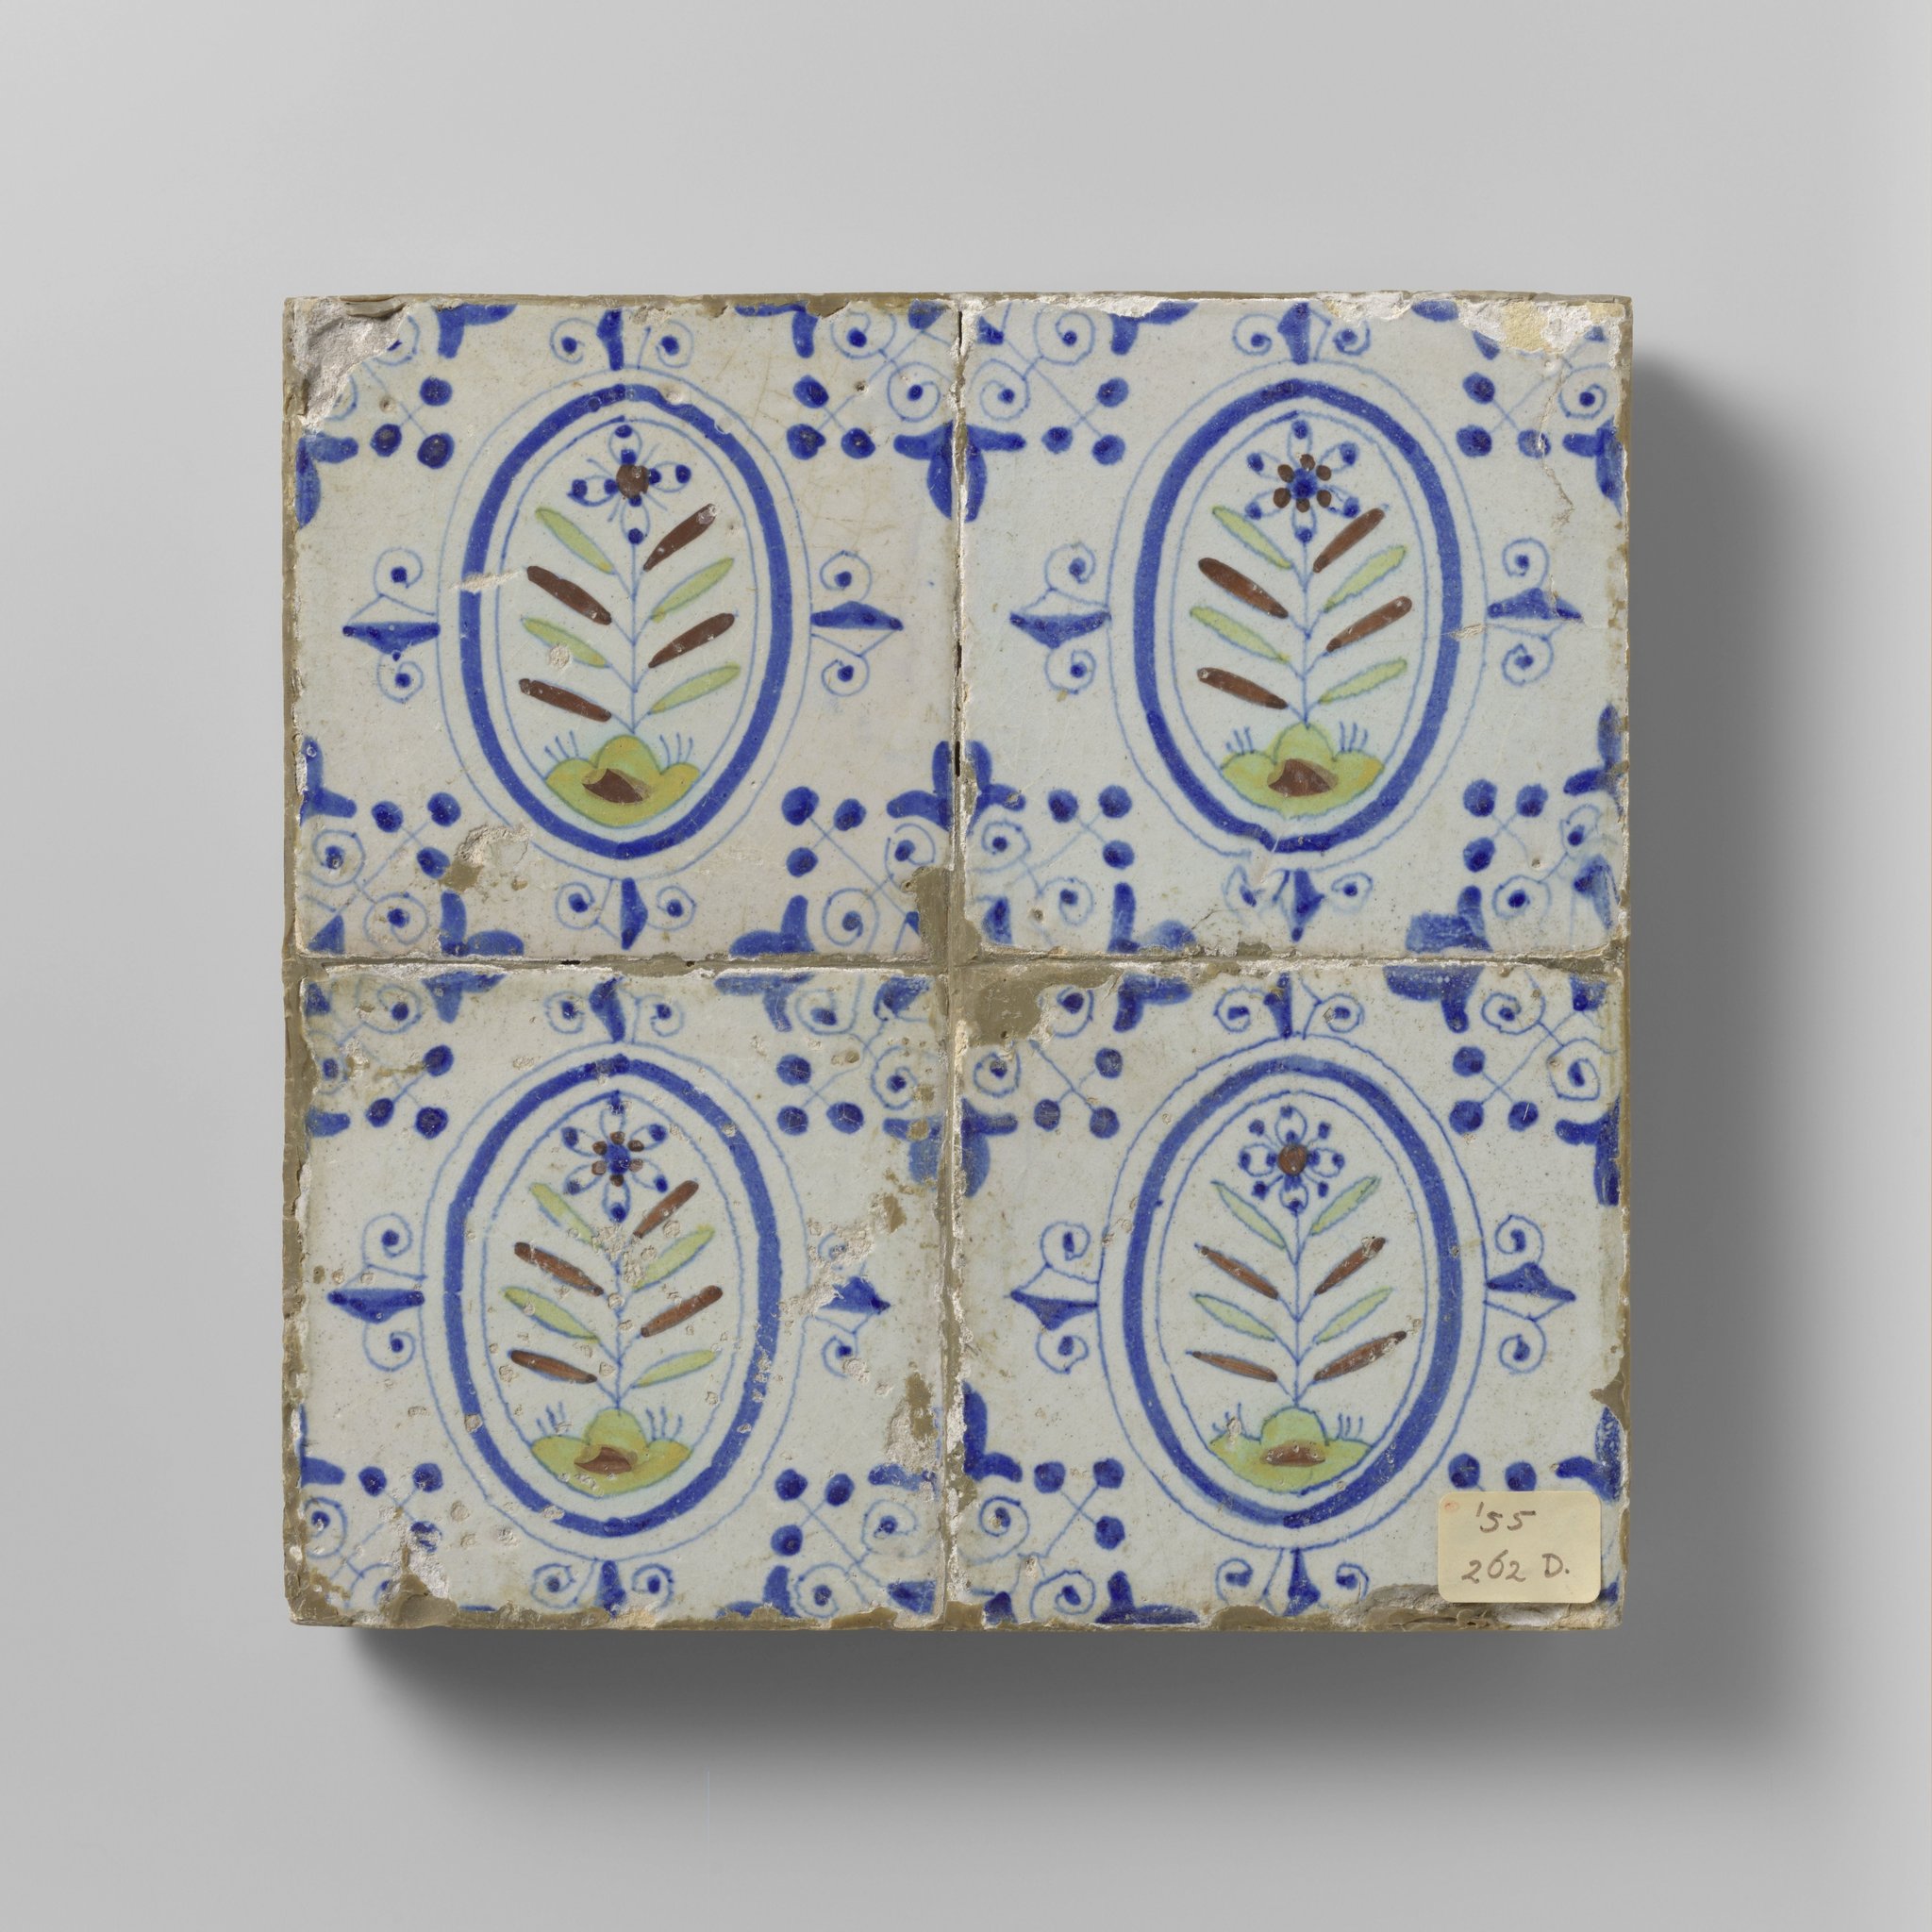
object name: tegelveld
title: Veld van vier tegels met bloemen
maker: Anonymous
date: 1640-1660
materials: earthenware, glaze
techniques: maiolica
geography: netherlands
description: Veld van vier tegels (2 x 2) elk met een veelkleurige (blauw, groen, geel en oranje) bloem op bol binnen een ovaal met lelie, en in de hoeken een driestip.